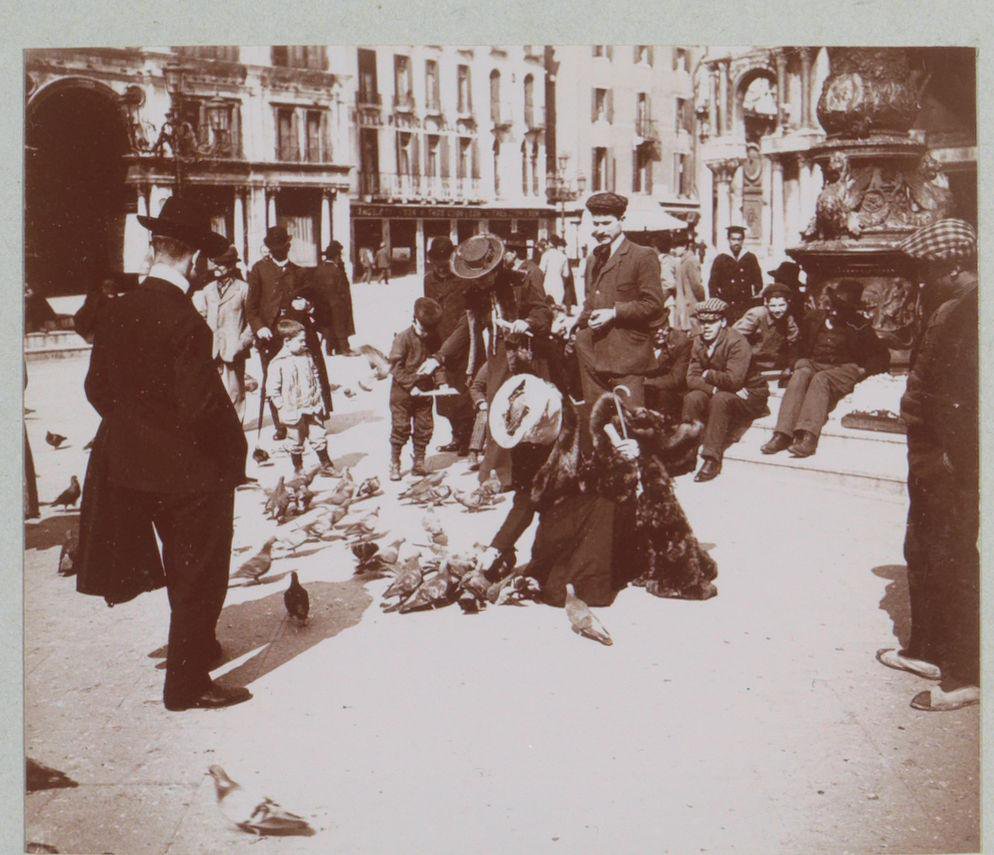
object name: photograph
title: Vrouw voert duiven op het San Marcoplein in Venetië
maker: Anonymous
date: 1905-1910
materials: paper, photographic support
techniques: gelatin silver print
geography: venice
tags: head-gear: hat, veil, square, place, circus, etc. (+ city(-scape) with figures, staffage), doves, pigeons, venice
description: Onderdeel van Fotoalbum van een Franse amateurfotograaf met bezienswaardigheden in Frankrijk, Zwitserland en Italië.